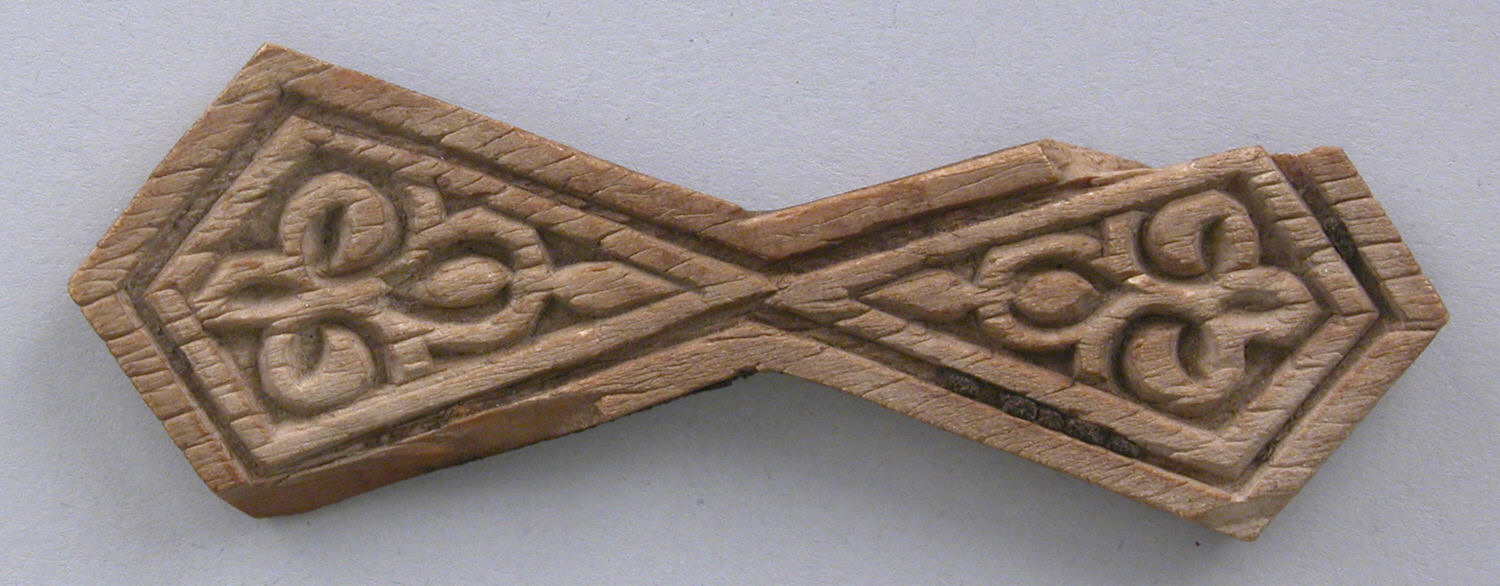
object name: panel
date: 1301-1500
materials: ivory, wood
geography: egypt